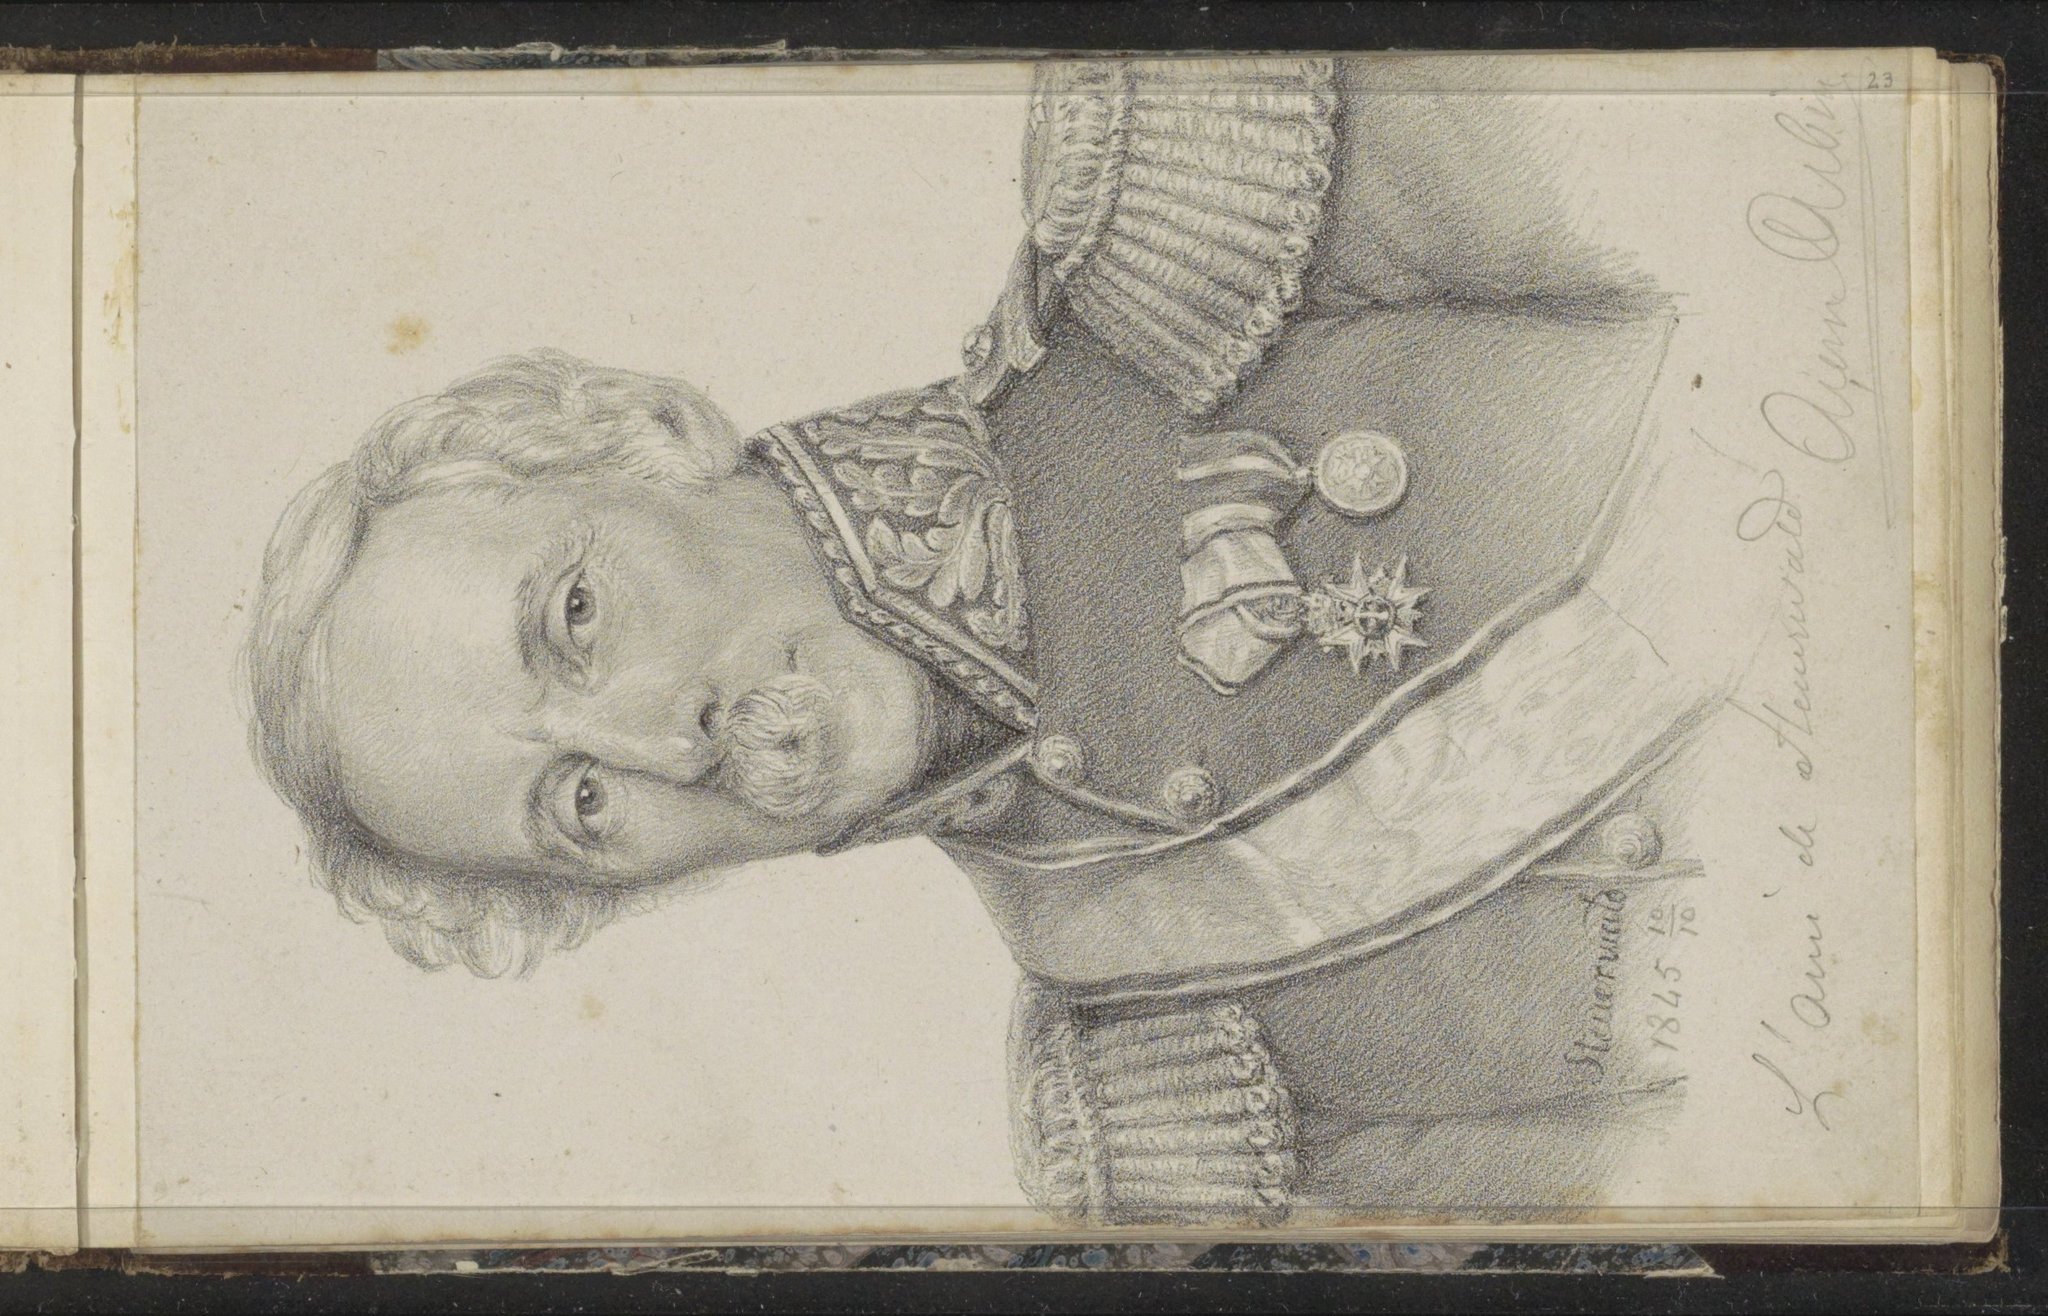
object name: sketchbook leaf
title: Portret van een bevriende militair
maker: christian heinrich gottlieb steuerwald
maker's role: draughtsman, print maker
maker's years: 1802-1874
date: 1810-1845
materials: paper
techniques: lithograph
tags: (military) uniforms, historical persons (portraits and scenes from the life)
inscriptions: signature and date: ‘Steuerwald/ 1845/ 10-10’, annotation: ‘L'ami de Steuerwald/ [...]iem Rubin?’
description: Blad 23 recto uit een schetsboek met 61 bladen.